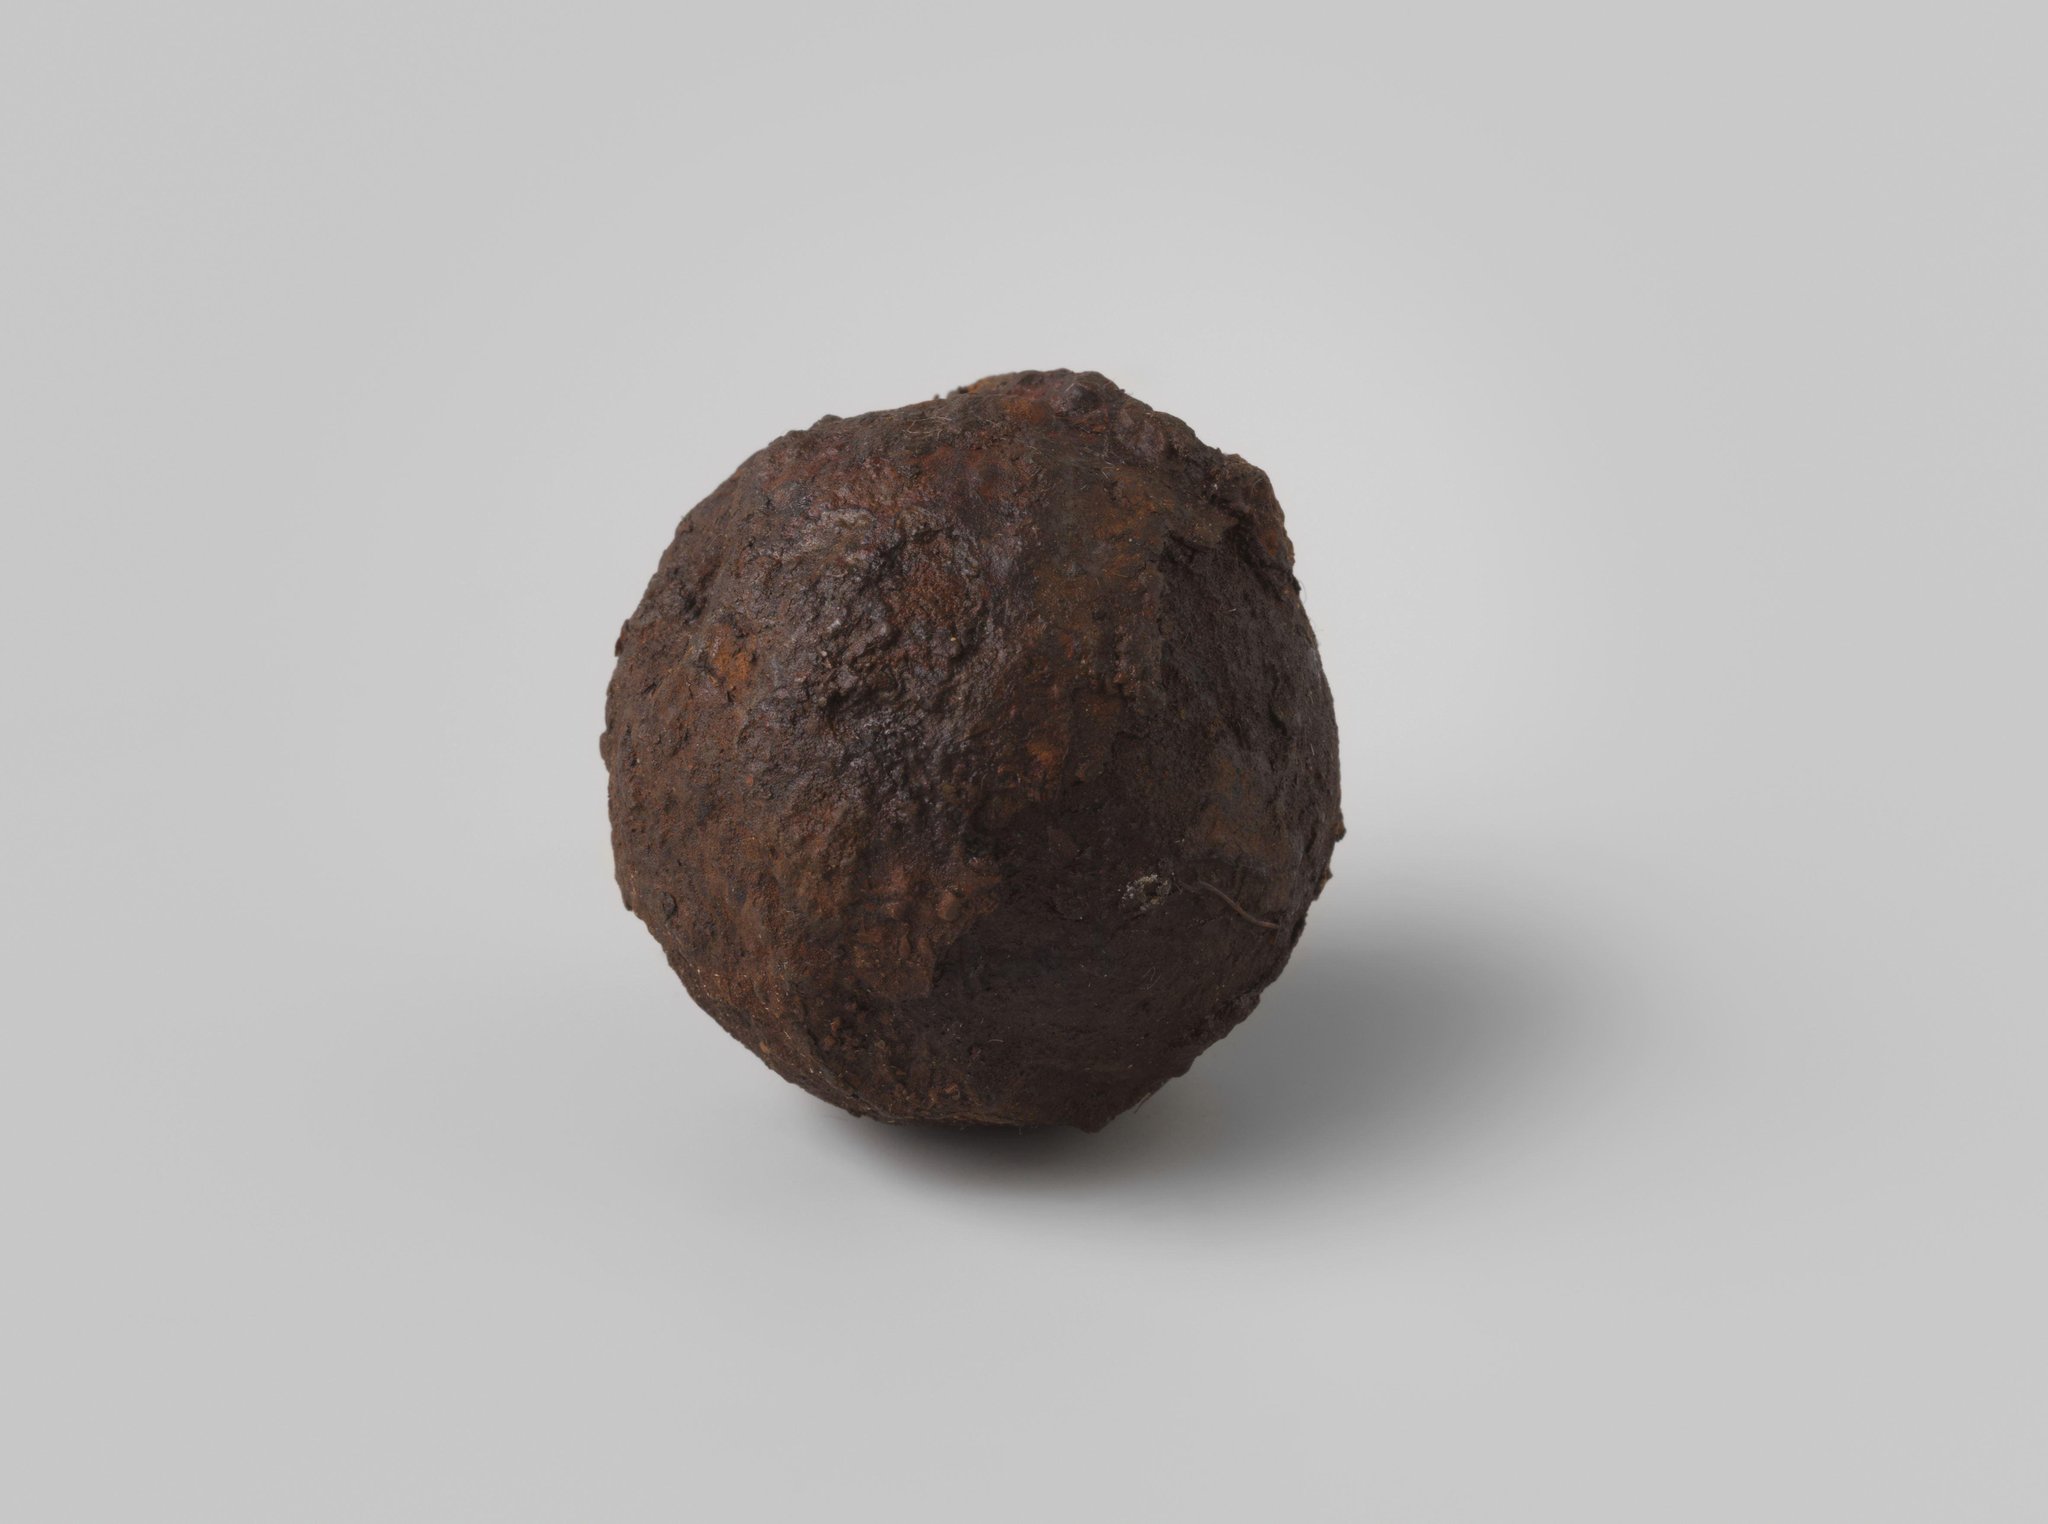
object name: bullet ammunition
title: Kogel uit het wrak van de Oost-Indiëvaarder Hollandia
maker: Anonymous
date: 1700-1743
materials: iron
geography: netherlands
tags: verenigde oostindische compagnie, hollandia (schip), annet